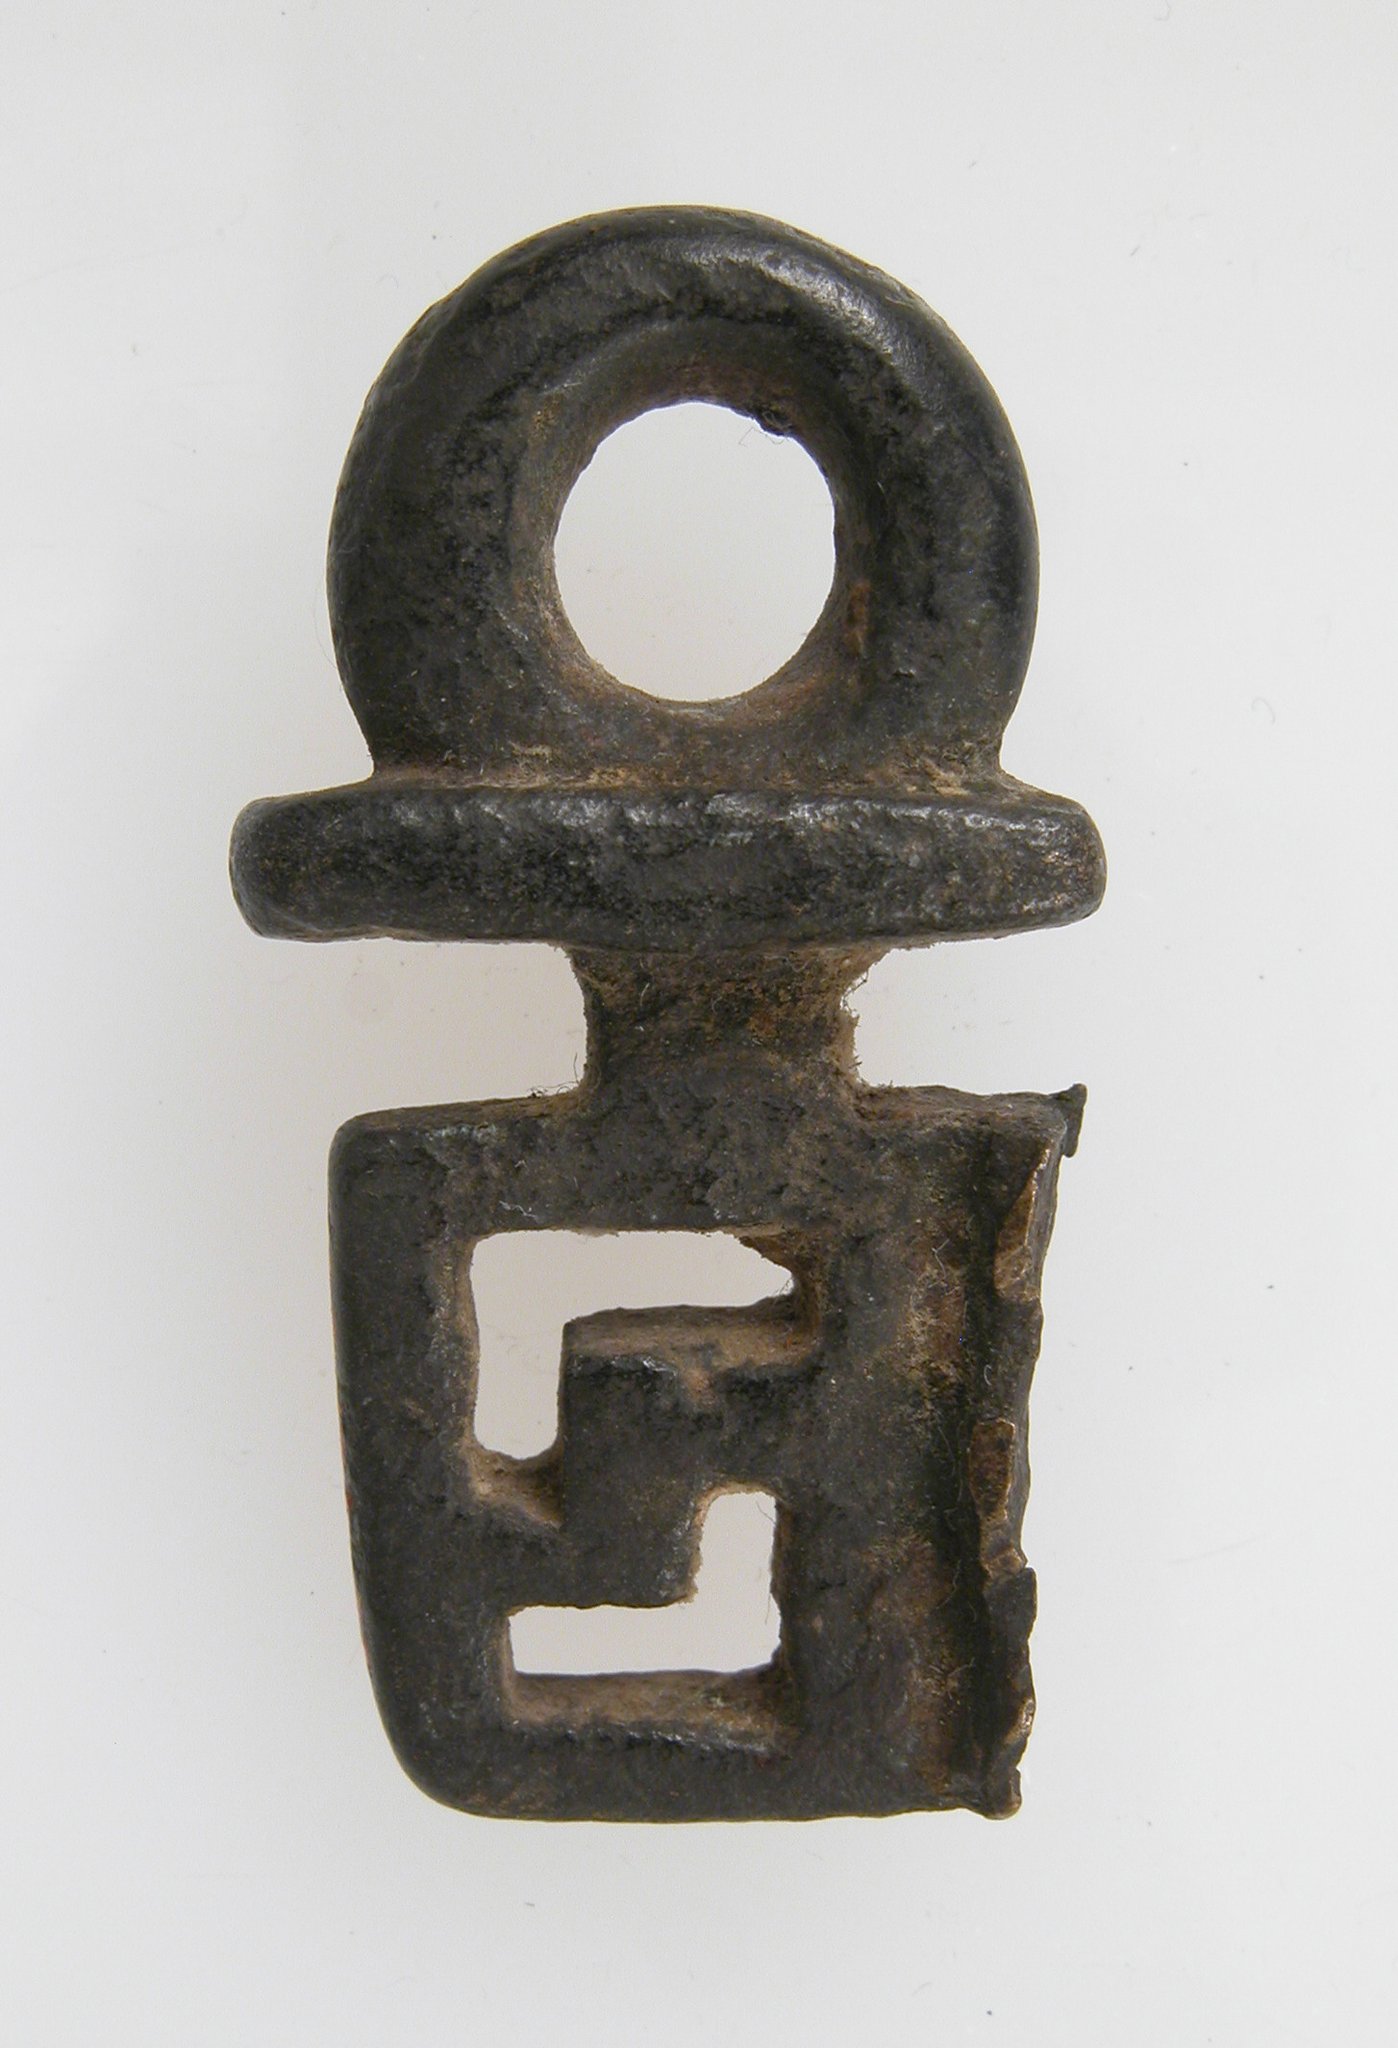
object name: key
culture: roman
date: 1-700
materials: copper alloy